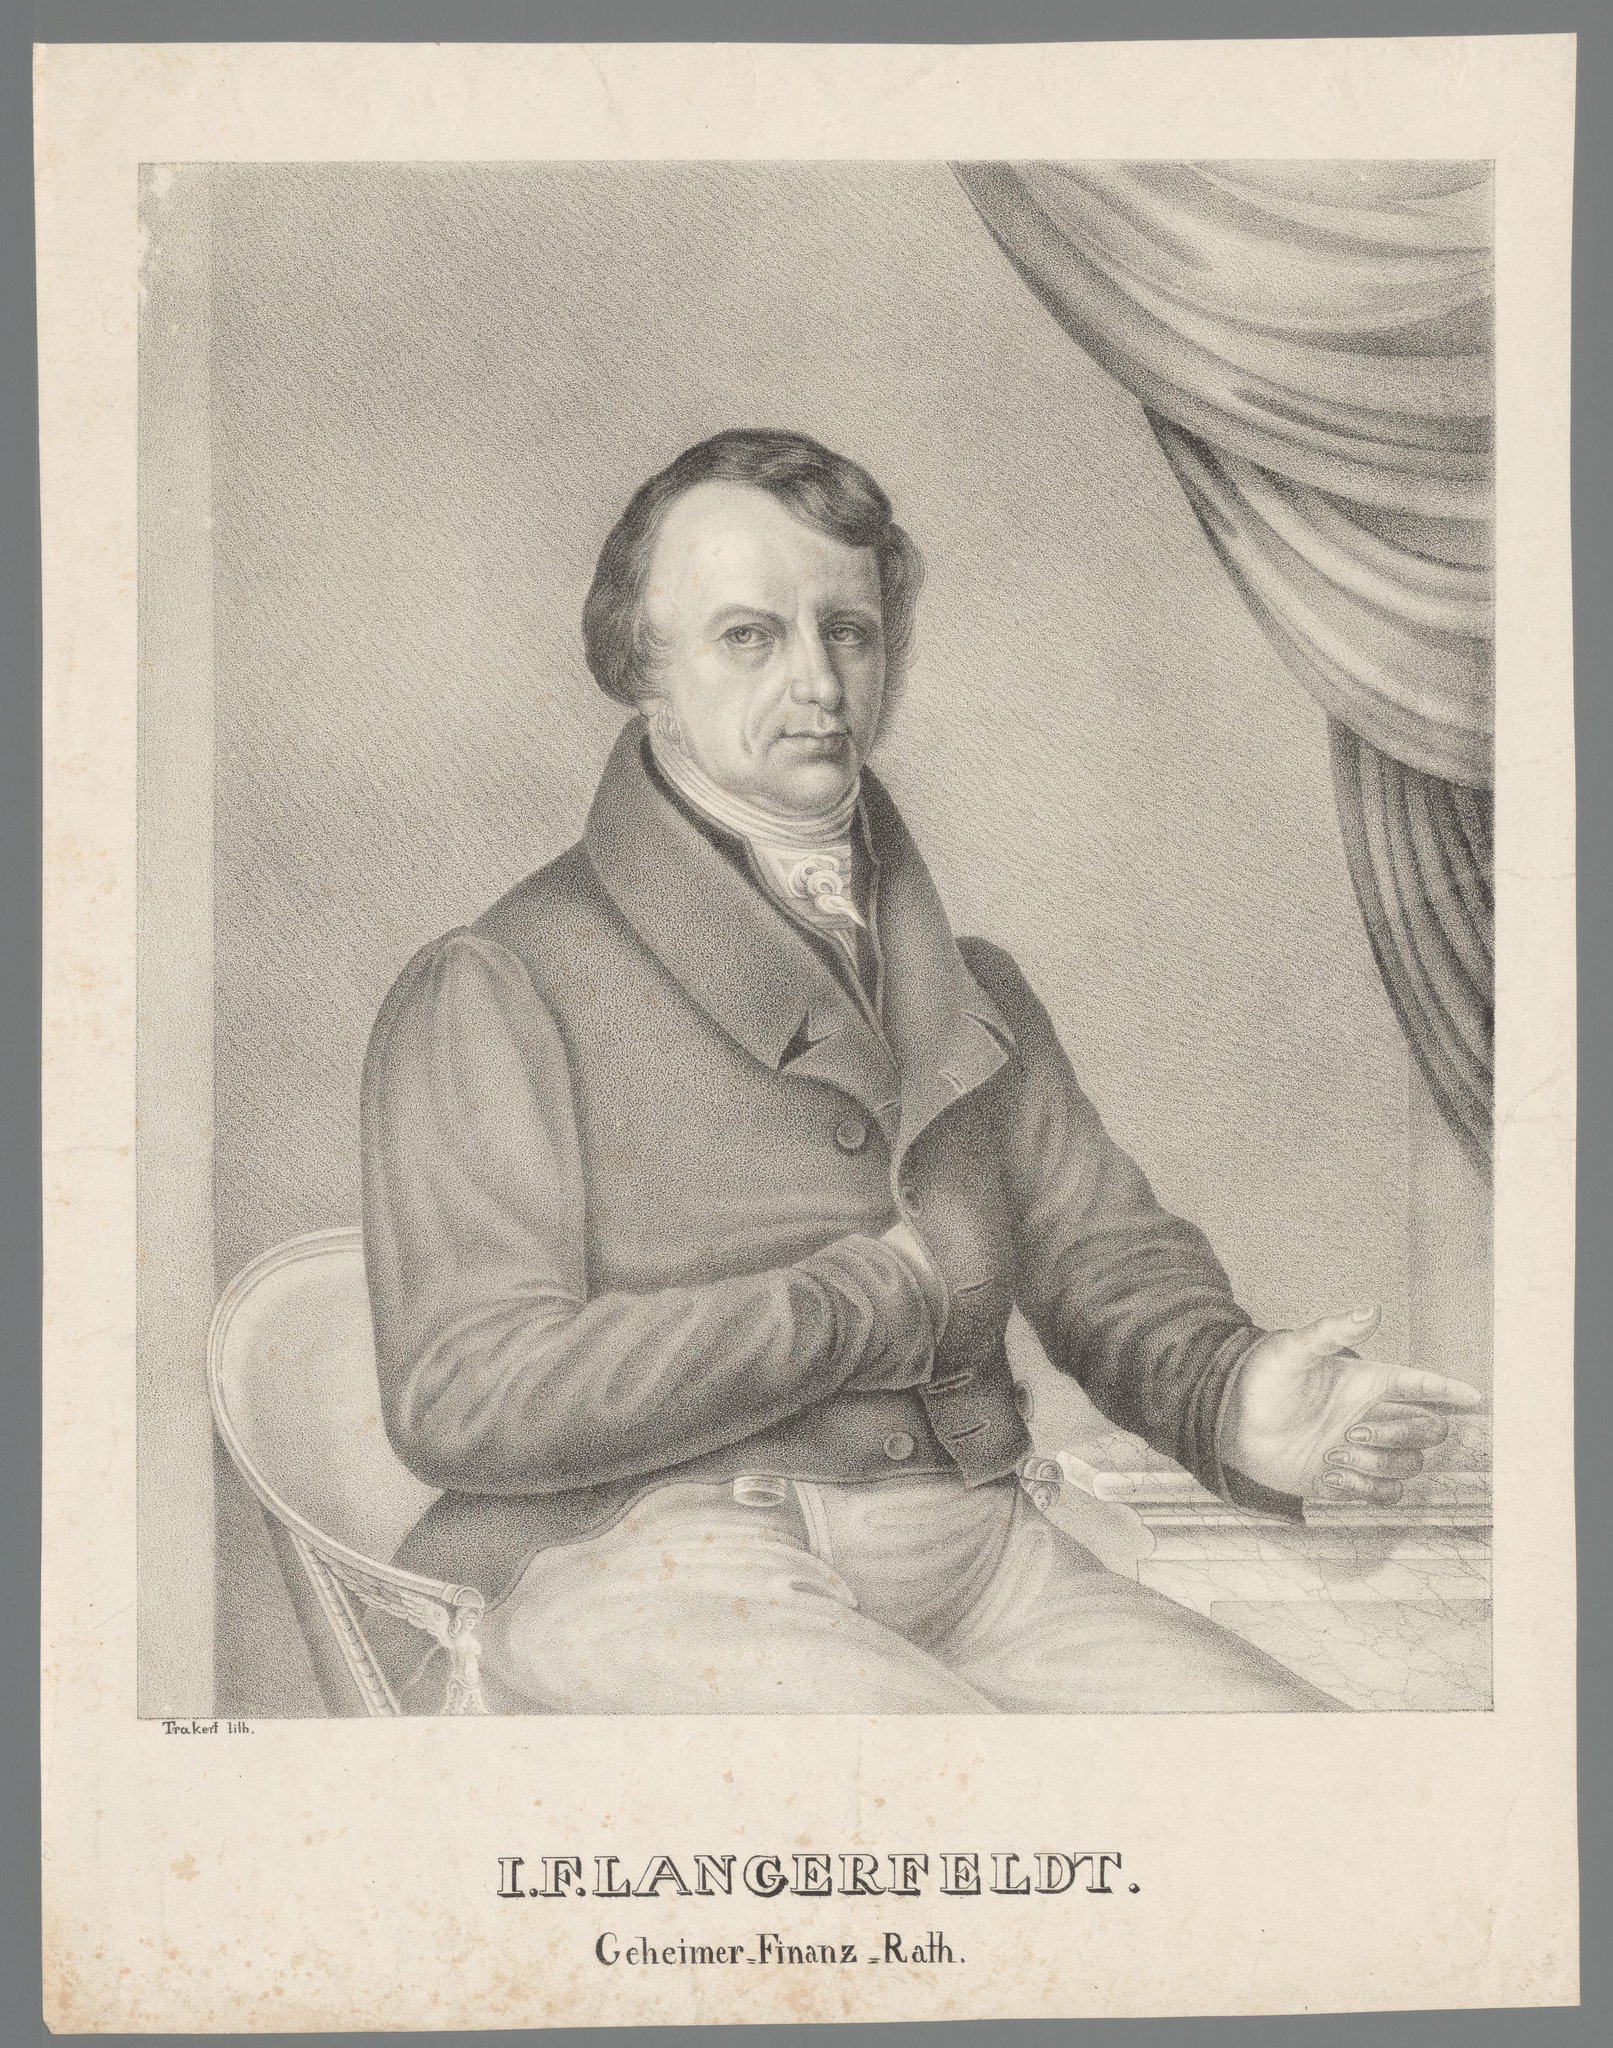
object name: print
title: Portret van I.F. Langerfeldt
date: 1820-1890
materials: paper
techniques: lithograph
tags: adult man, historical persons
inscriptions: collector's mark: Lugt 2228